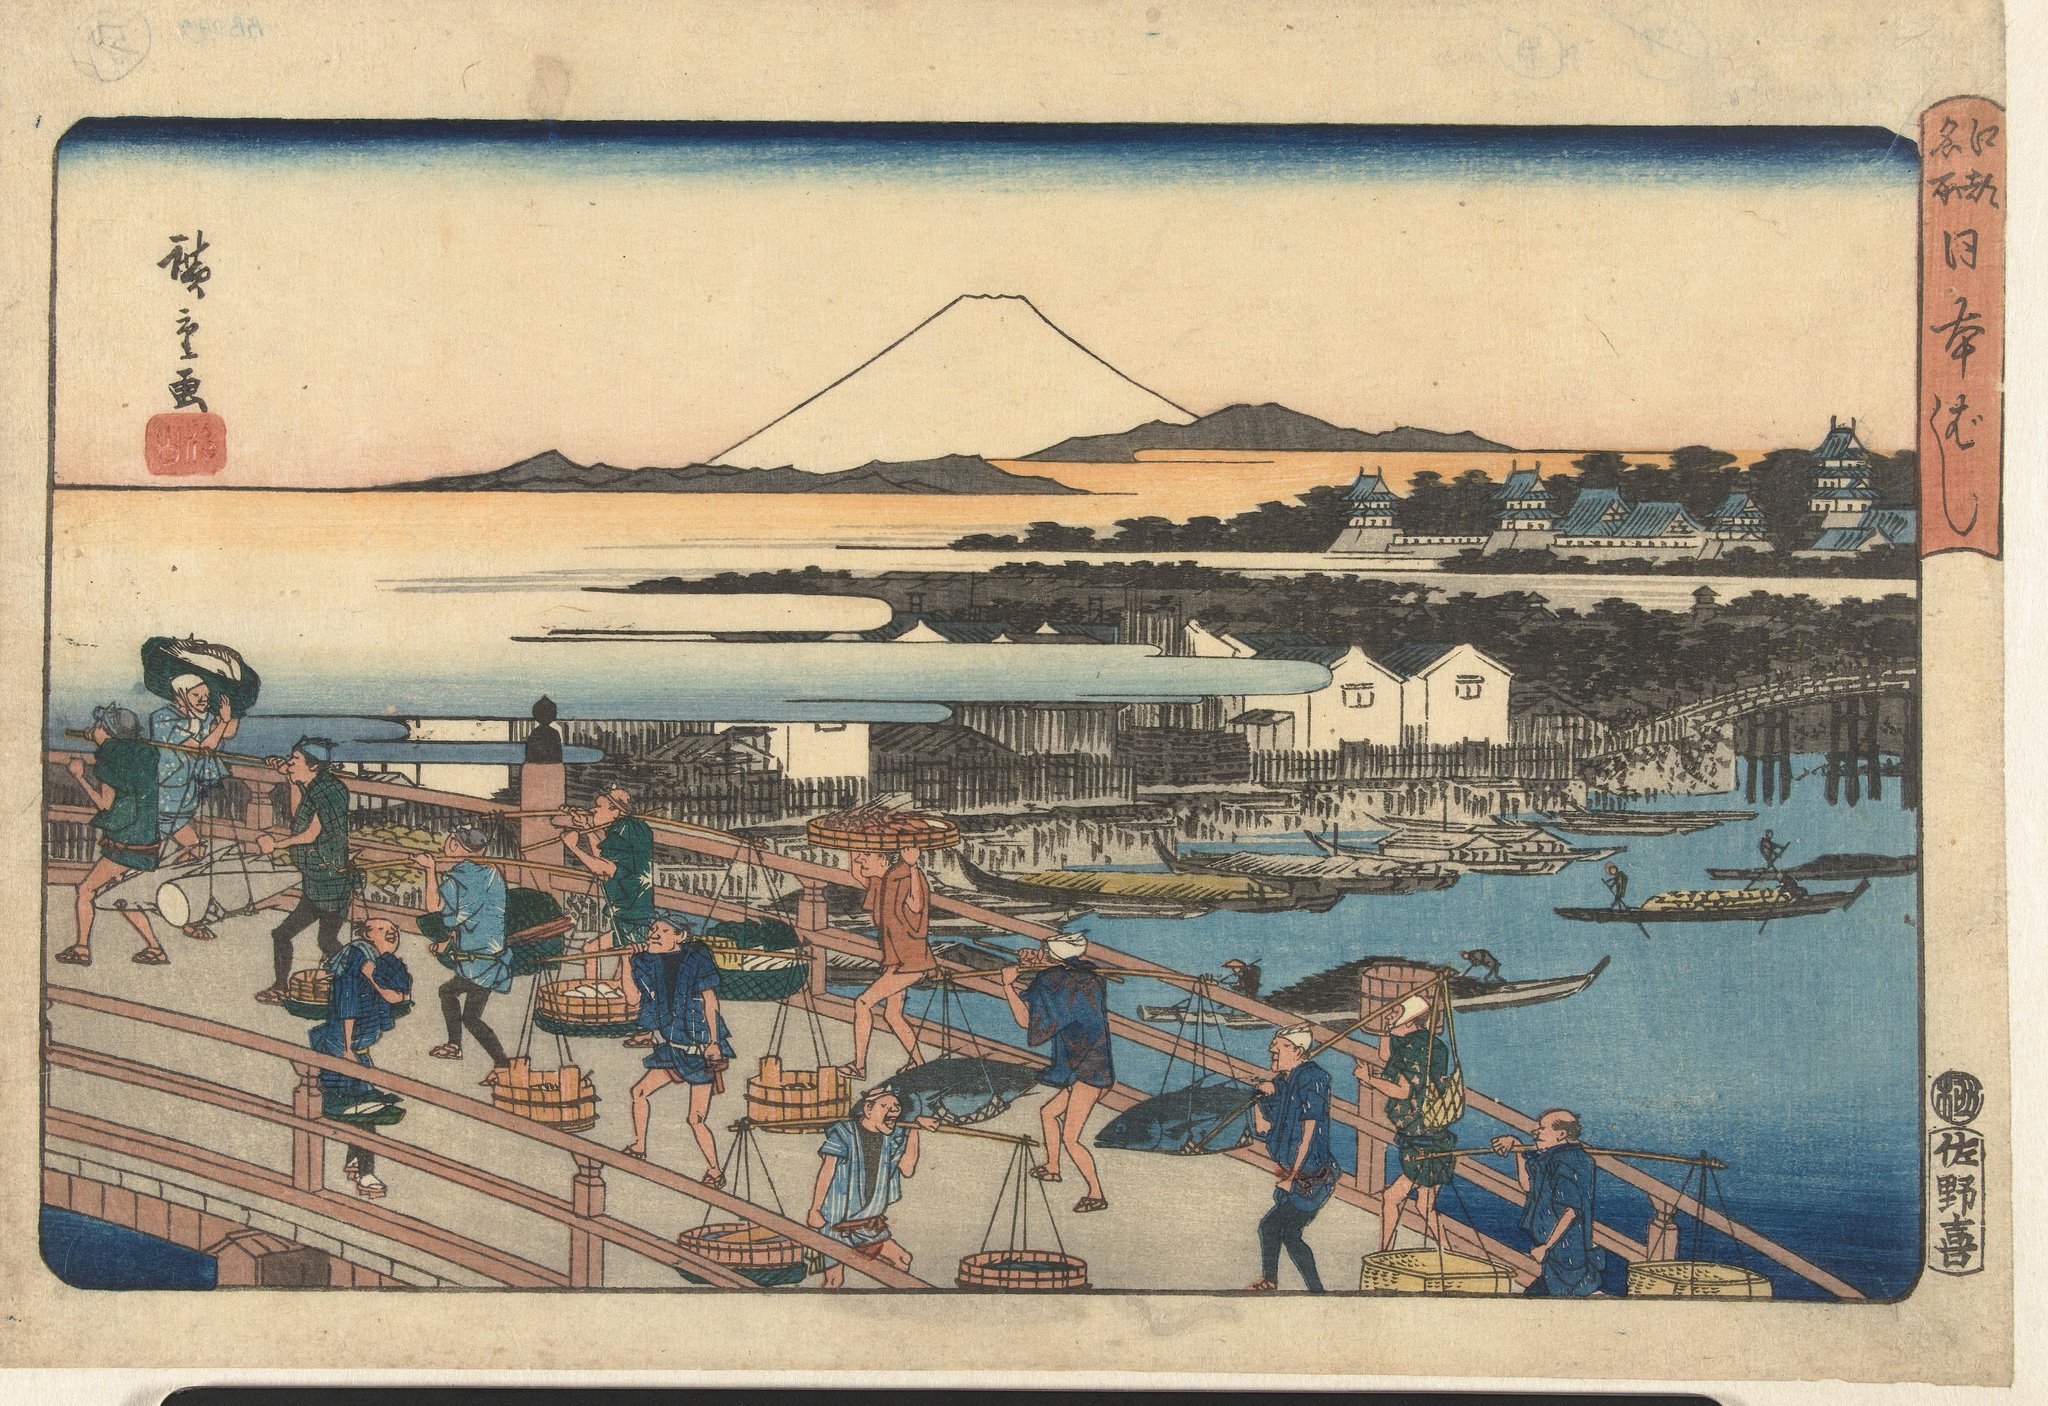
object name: print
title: Nihonbashi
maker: utagawa hiroshige (i)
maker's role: draughtsman, print maker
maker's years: 1797-1858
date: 1830-1840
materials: paper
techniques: woodcut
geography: tokyo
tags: bridge, persons engaged in trade and commerce